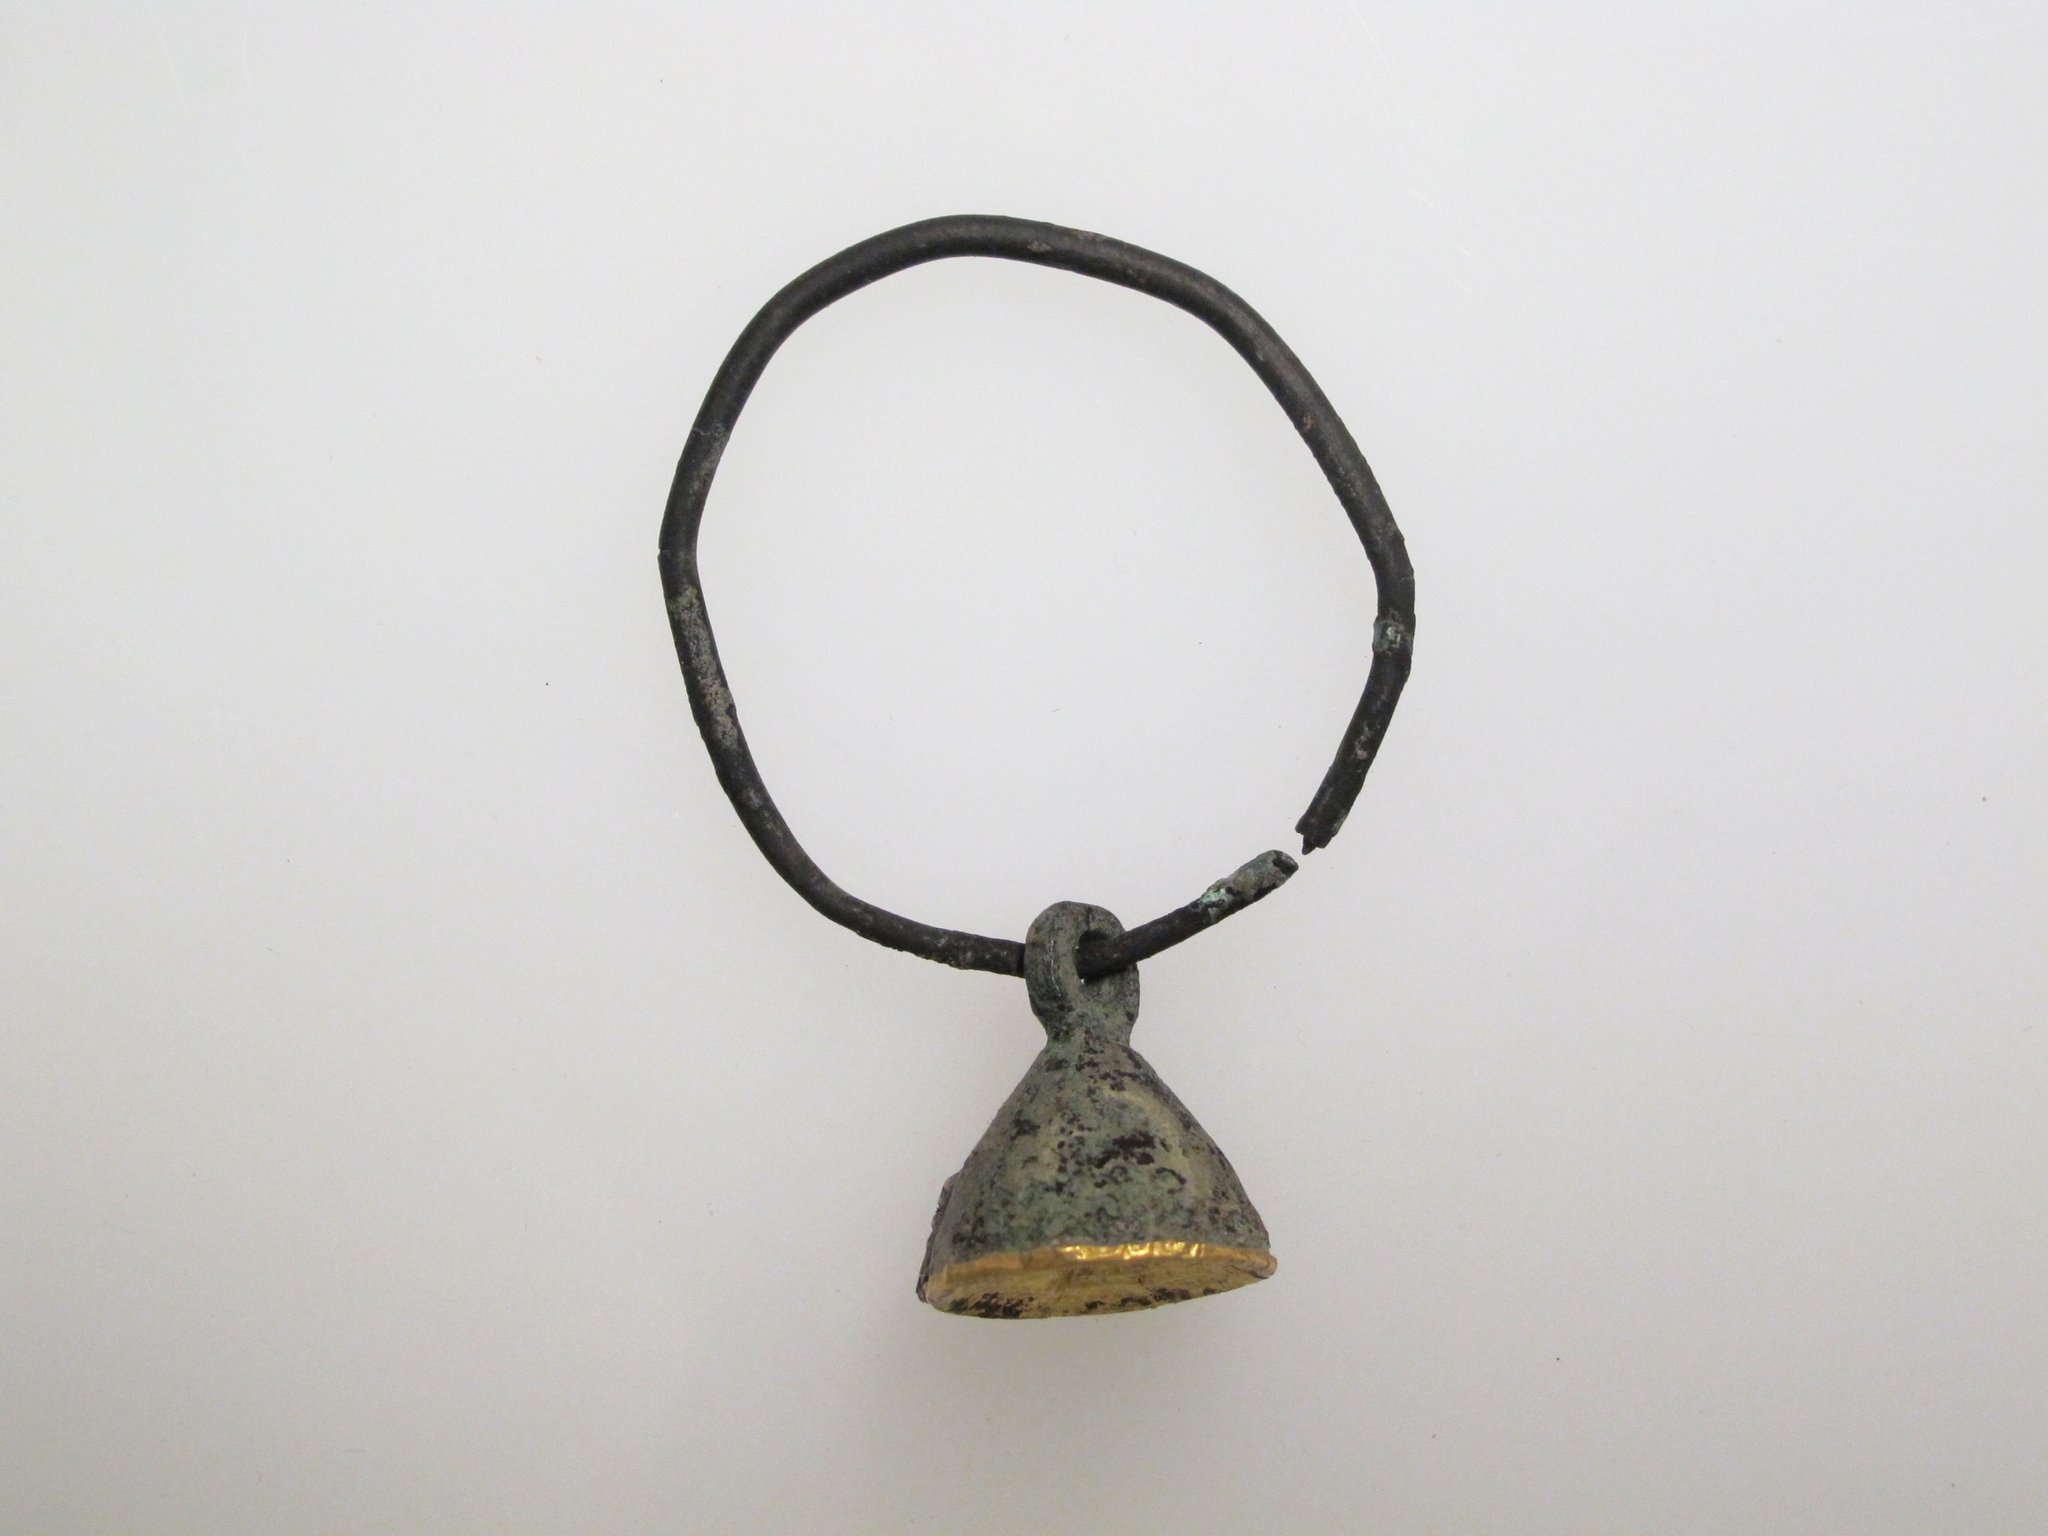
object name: bracelet with pendant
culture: roman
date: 201-300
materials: gold, silver